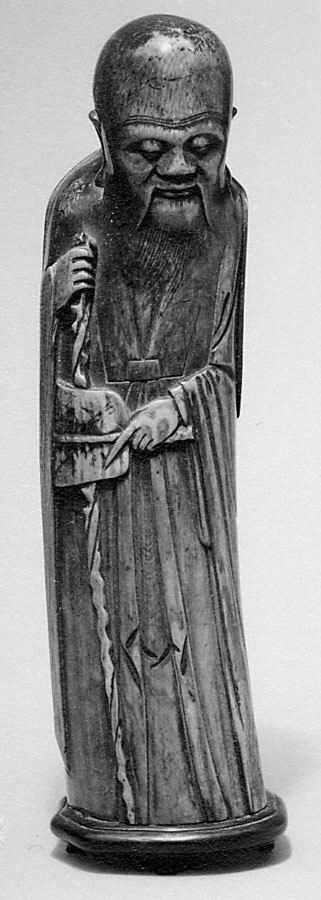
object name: statuette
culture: chinese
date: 1667-1700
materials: ivory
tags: men